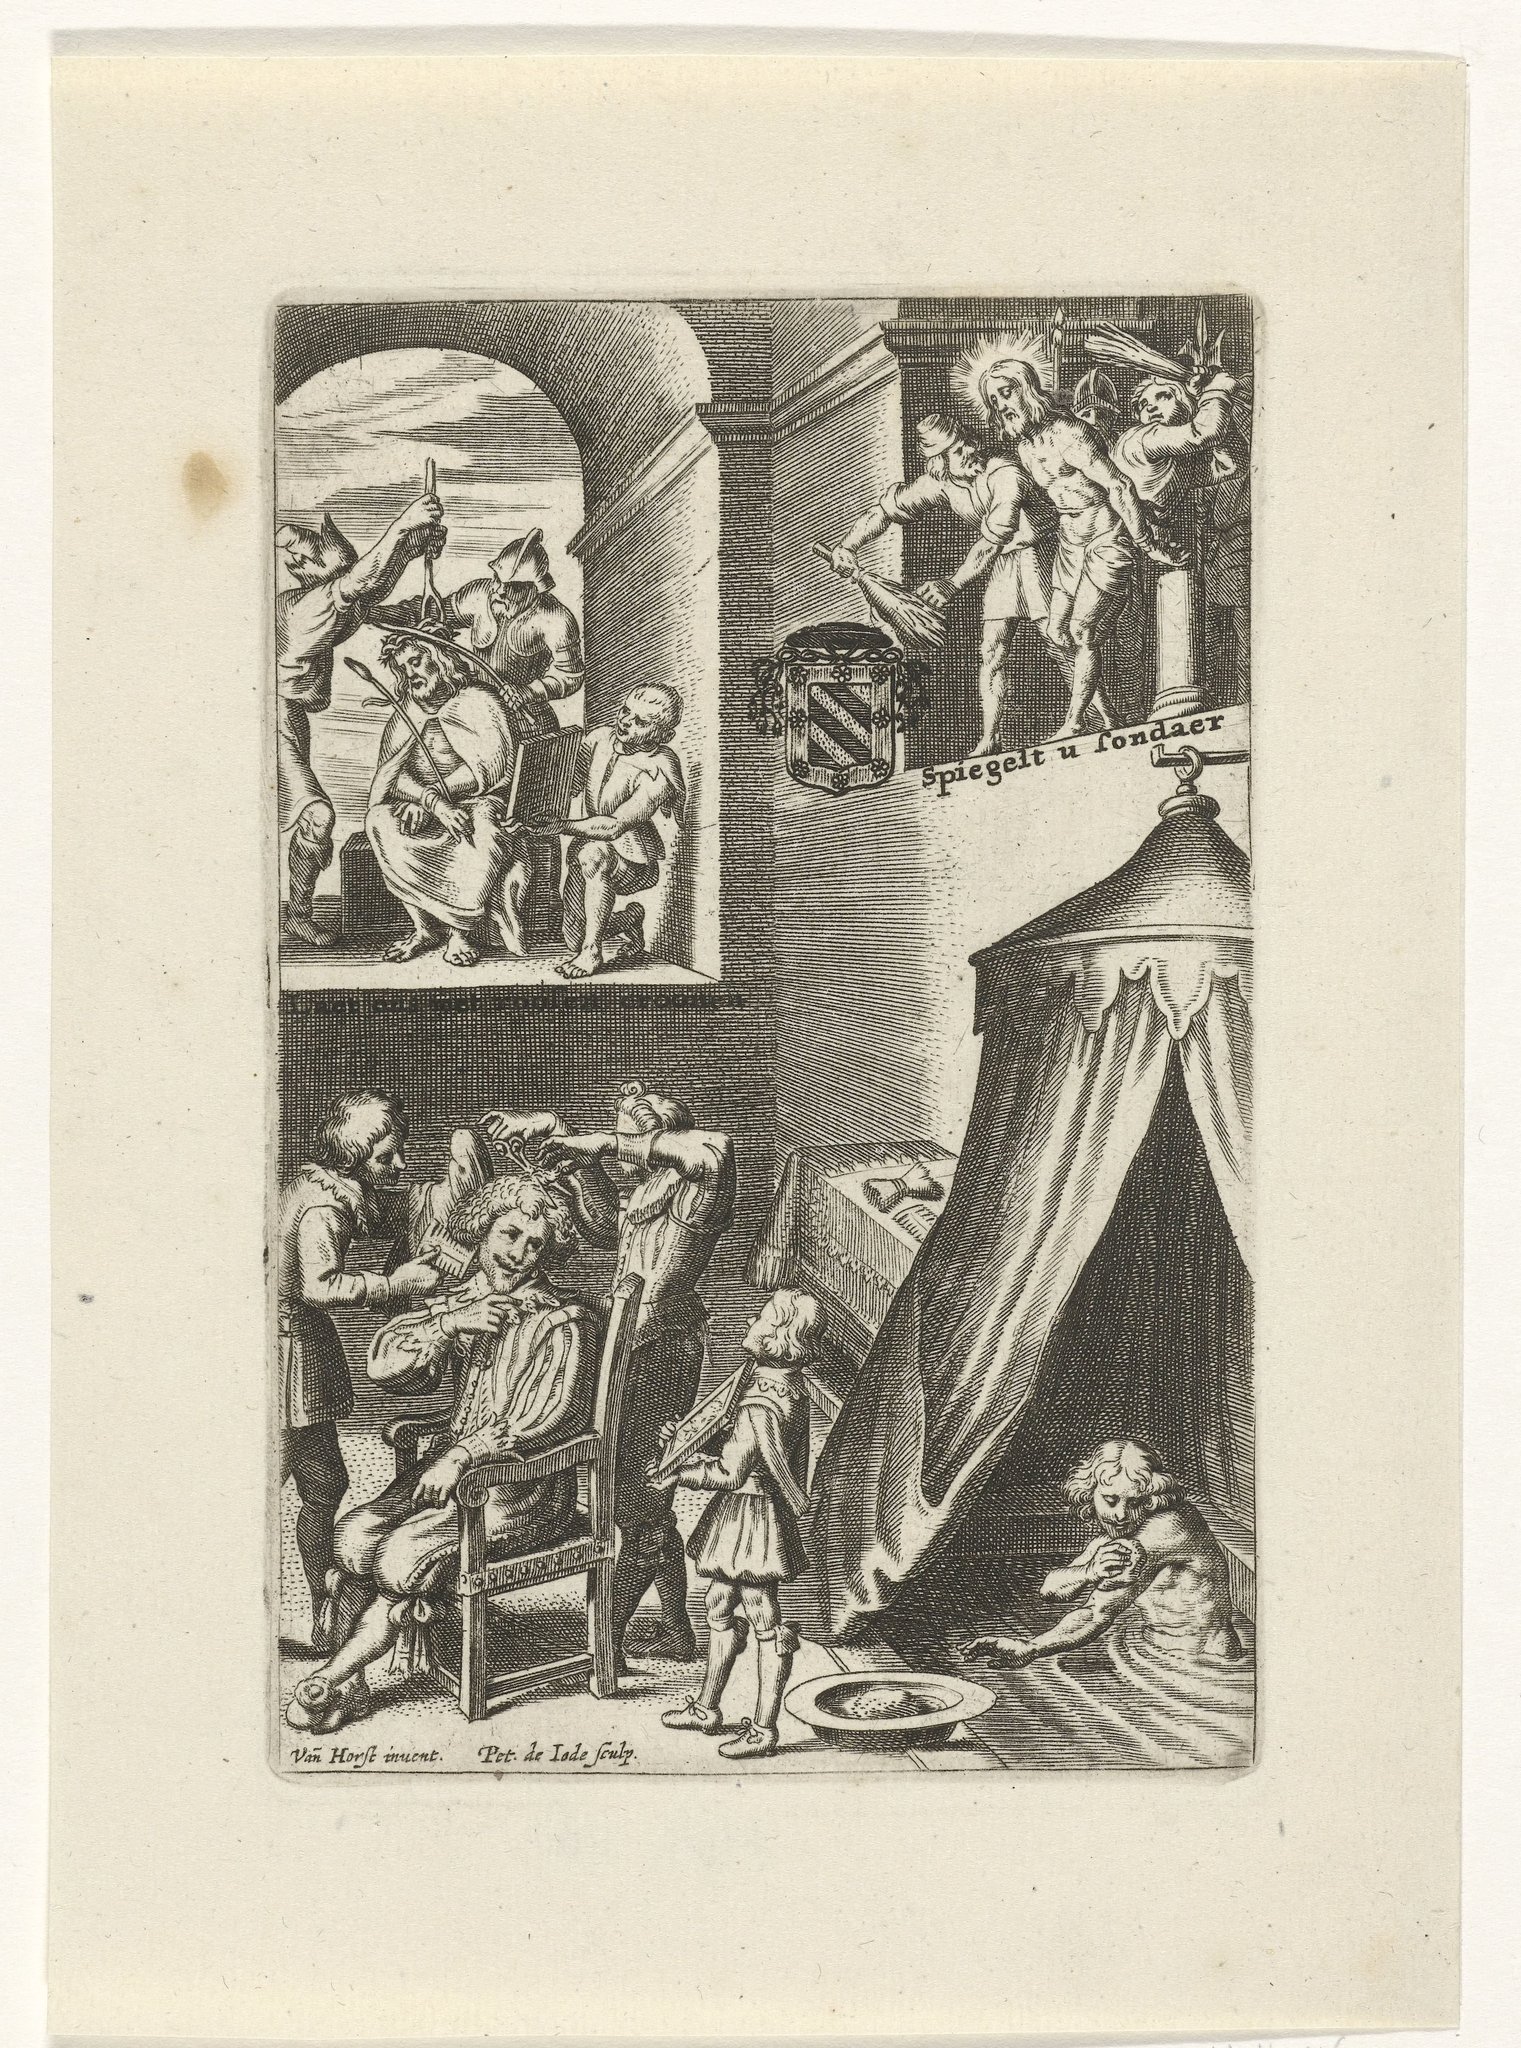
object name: print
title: Moraliserende lessen voor hovelingen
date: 1630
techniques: engraving, etching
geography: antwerp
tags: taking a bath, hair-cutting, the crowning with thorns: soldiers with sticks place a thorny crown on christ's head and give him a reed (matthew 27:27-31; mark 15:16-20; john 19:2-3), flagellation by soldiers, christ usually tied to a column (matthew 27:26; mark 15:15; john 19:1)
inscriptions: collector's mark: Lugt 2228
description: Op de voorgrond links wordt een hoveling door twee mannen geknipt en gekamd. Een jongen houdt hem een spiegel voor. Rechts een badende hoveling. Linksboven twee soldaten die met stokken de doornenkroon op Christus' hoofd duwen. Een derde man houdt hem een spiegel voor. Rechtsboven Christus, op lendendoek na naakt en vastgebonden aan een pilaar, door twee soldaten gegeseld. Midden boven een wapenschild van een kanunnik. De prent heeft een titel in het Nederlands. Prent uit een boekuitgave waarin steeds een scène uit het leven van Christus tegenover een wereldse situatie is gesteld.